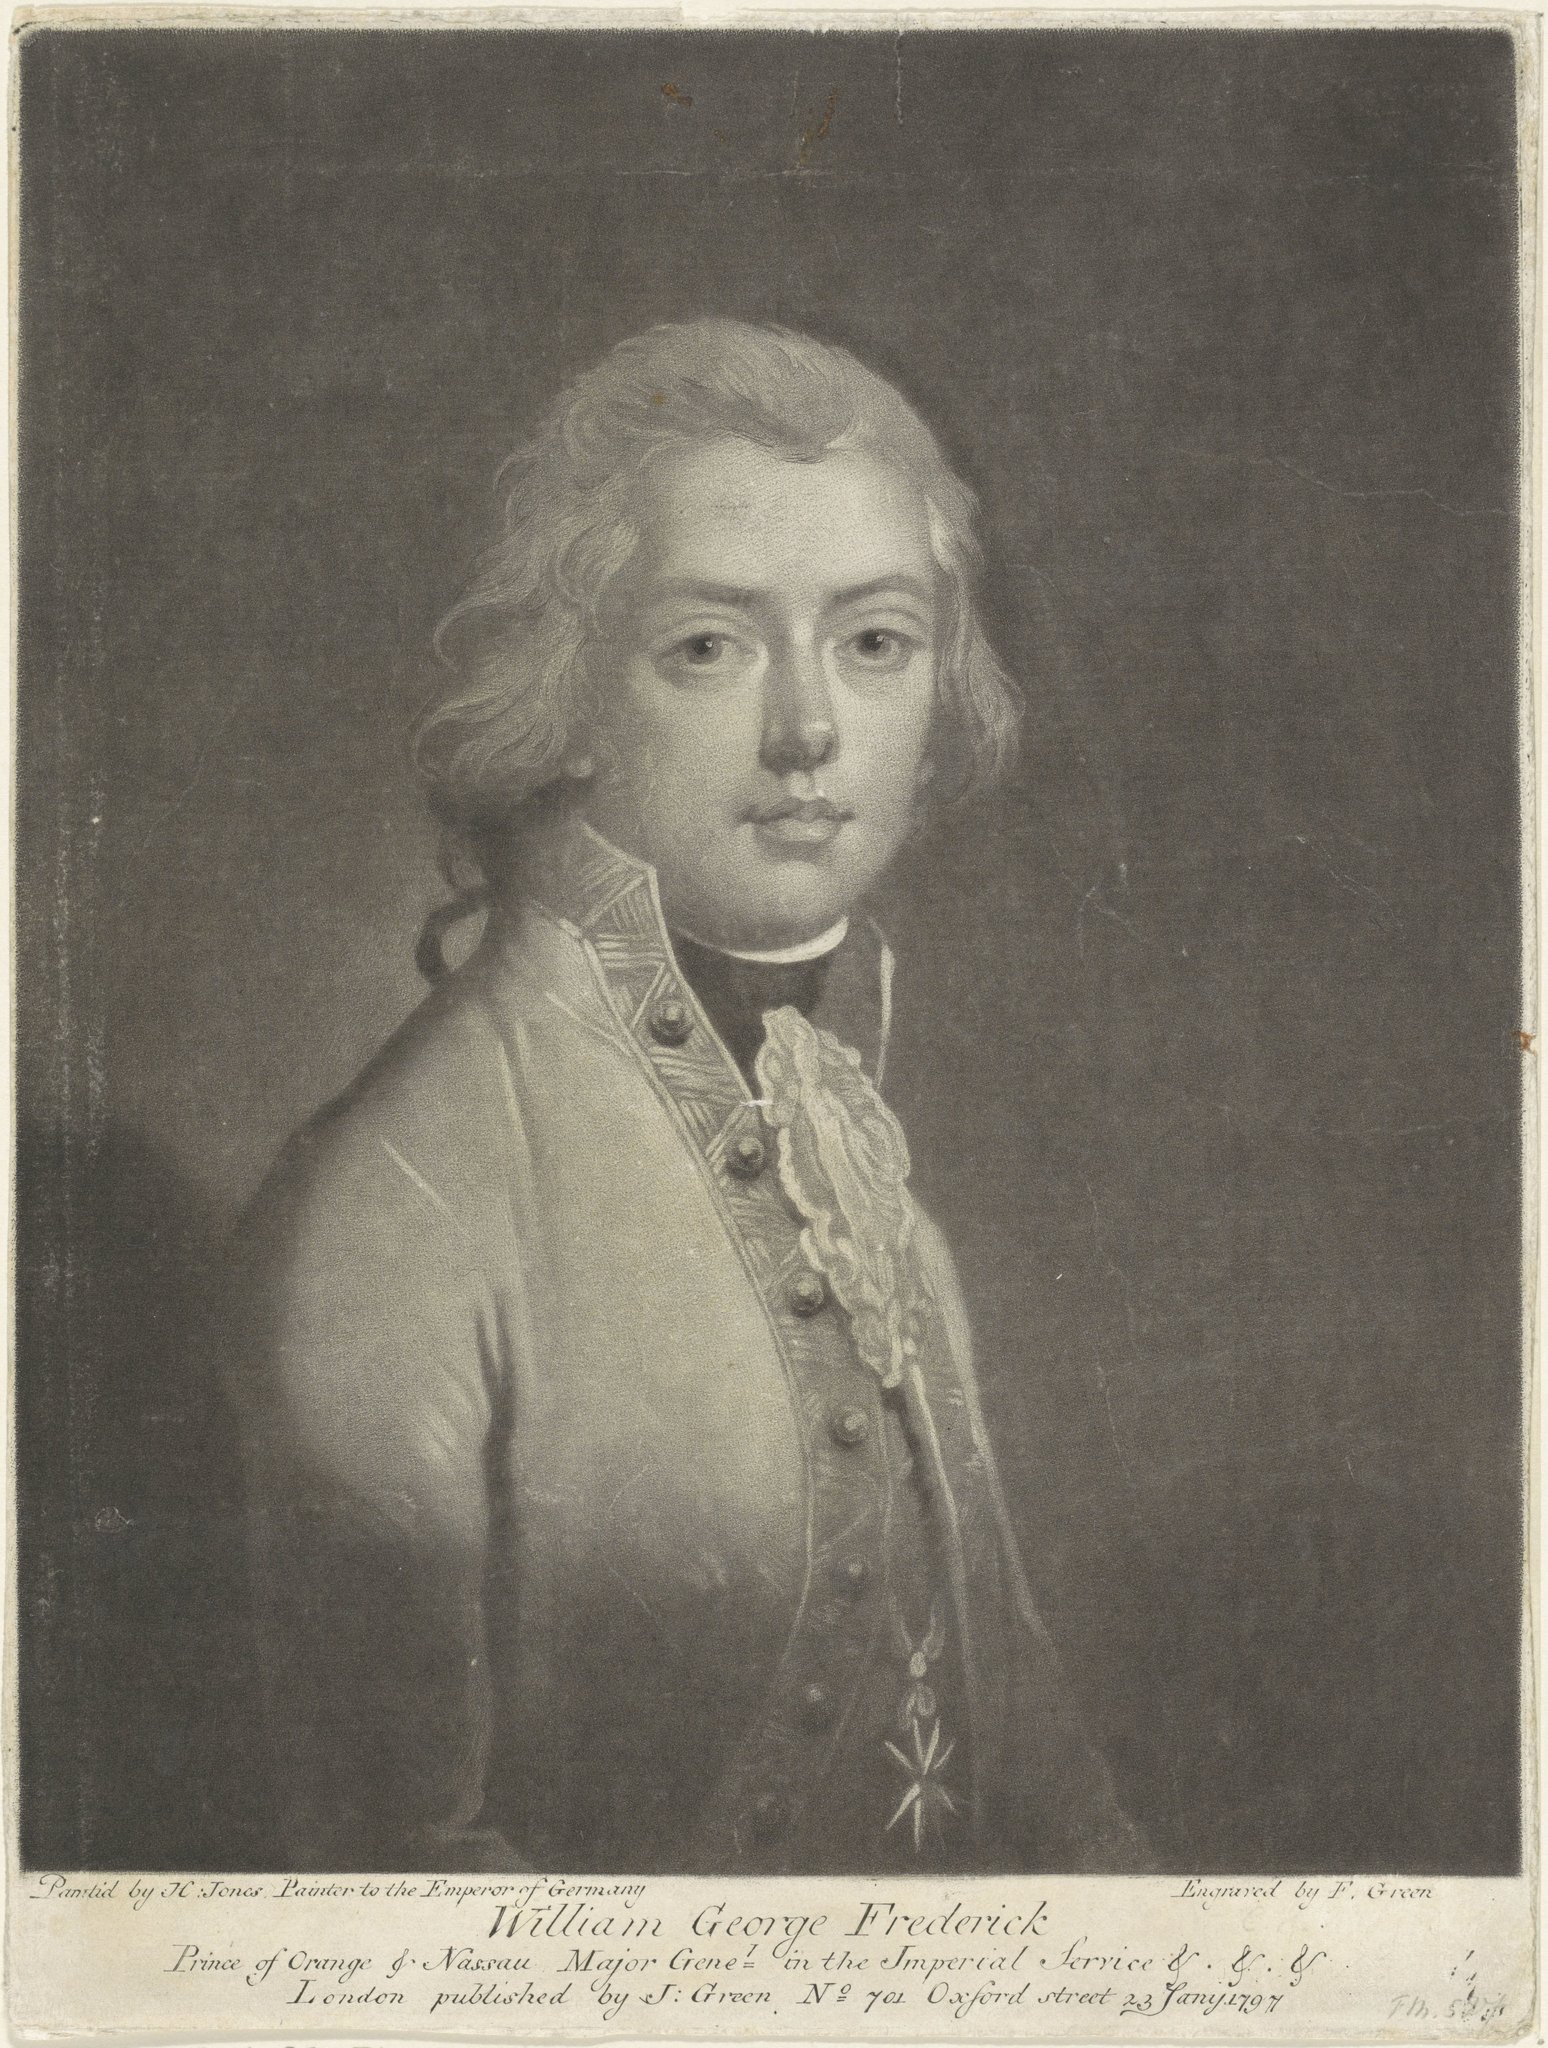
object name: print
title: Portret van Frederik, prins van Oranje-Nassau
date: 1797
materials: paper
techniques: mezzotint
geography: england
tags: the hague, willem george frederik (prins van oranje-nassau)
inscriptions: collector's mark: Lugt 2228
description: De hier vermelde titel verwijst naar de hoogst verkregen titel van de geportretteerde, niet per se naar de titel die de geportretteerde op deze voorstelling draagt.